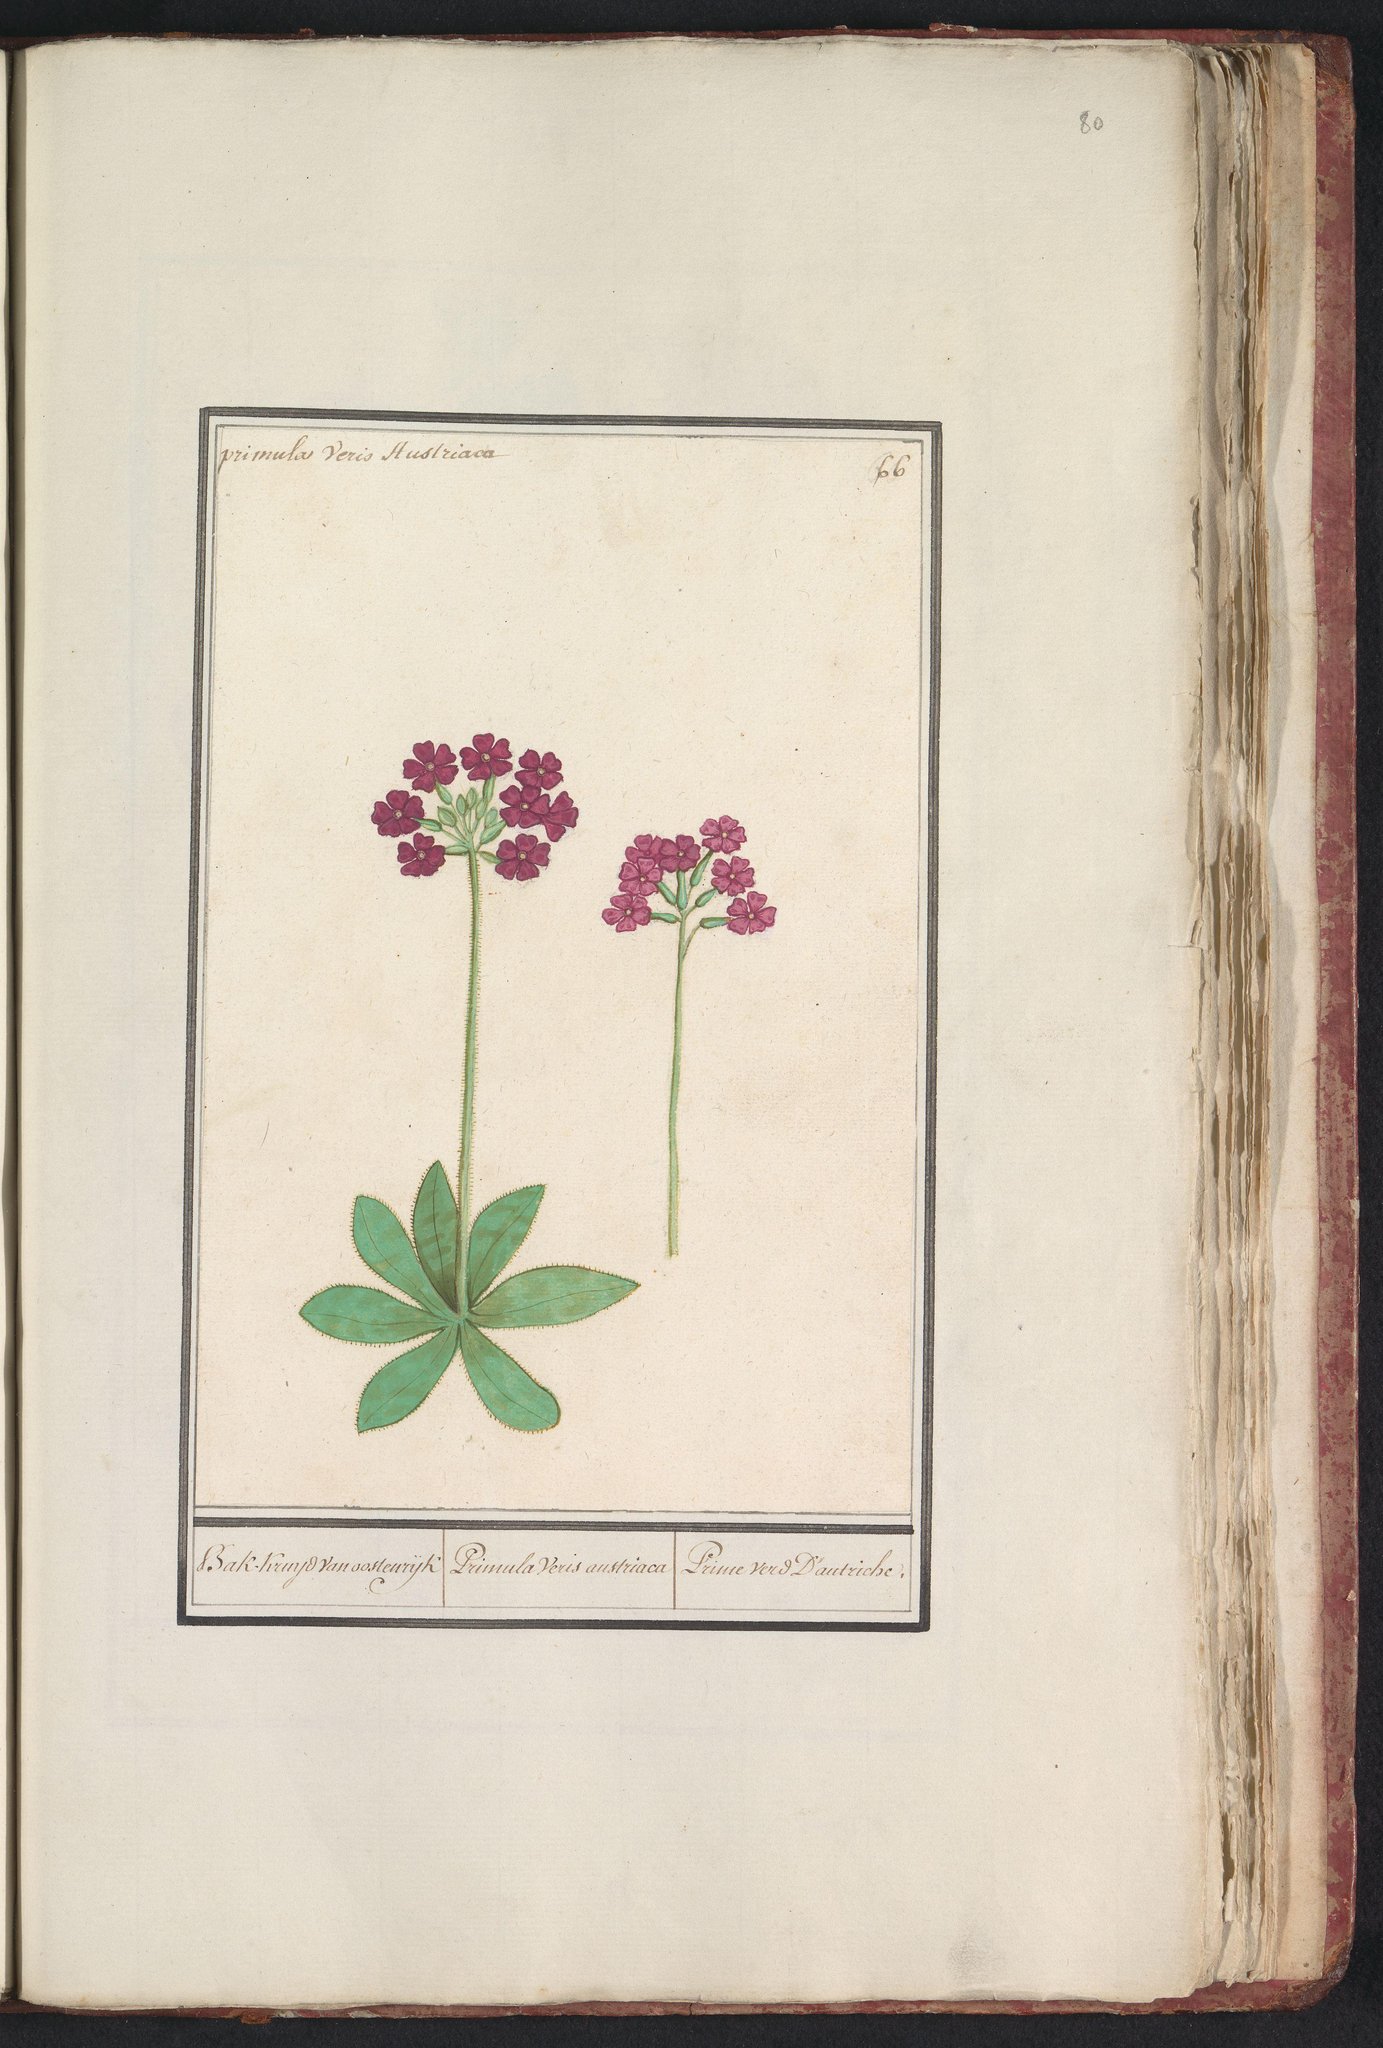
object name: drawing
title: Bak-Kruyd van oostenrijk / Primula Veris austriaca / Prime verd D'autriche.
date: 1596-1610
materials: chalk, paint, ink, paper, watercolor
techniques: brush, pen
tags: flowers: primula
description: Sleutelbloem (Primula) met donkerroze bloemen. Genummerd rechtsboven: 66. Linksboven de Latijnse naam. Onderdeel van het eerste album met tekeningen van bloemen en planten. Achtste van twaalf albums met tekeningen van dieren, vogels en planten bekend rond 1600, gemaakt in opdracht van keizer Rudolf II. Met toelichting in Nederlands, Latijn en Frans.